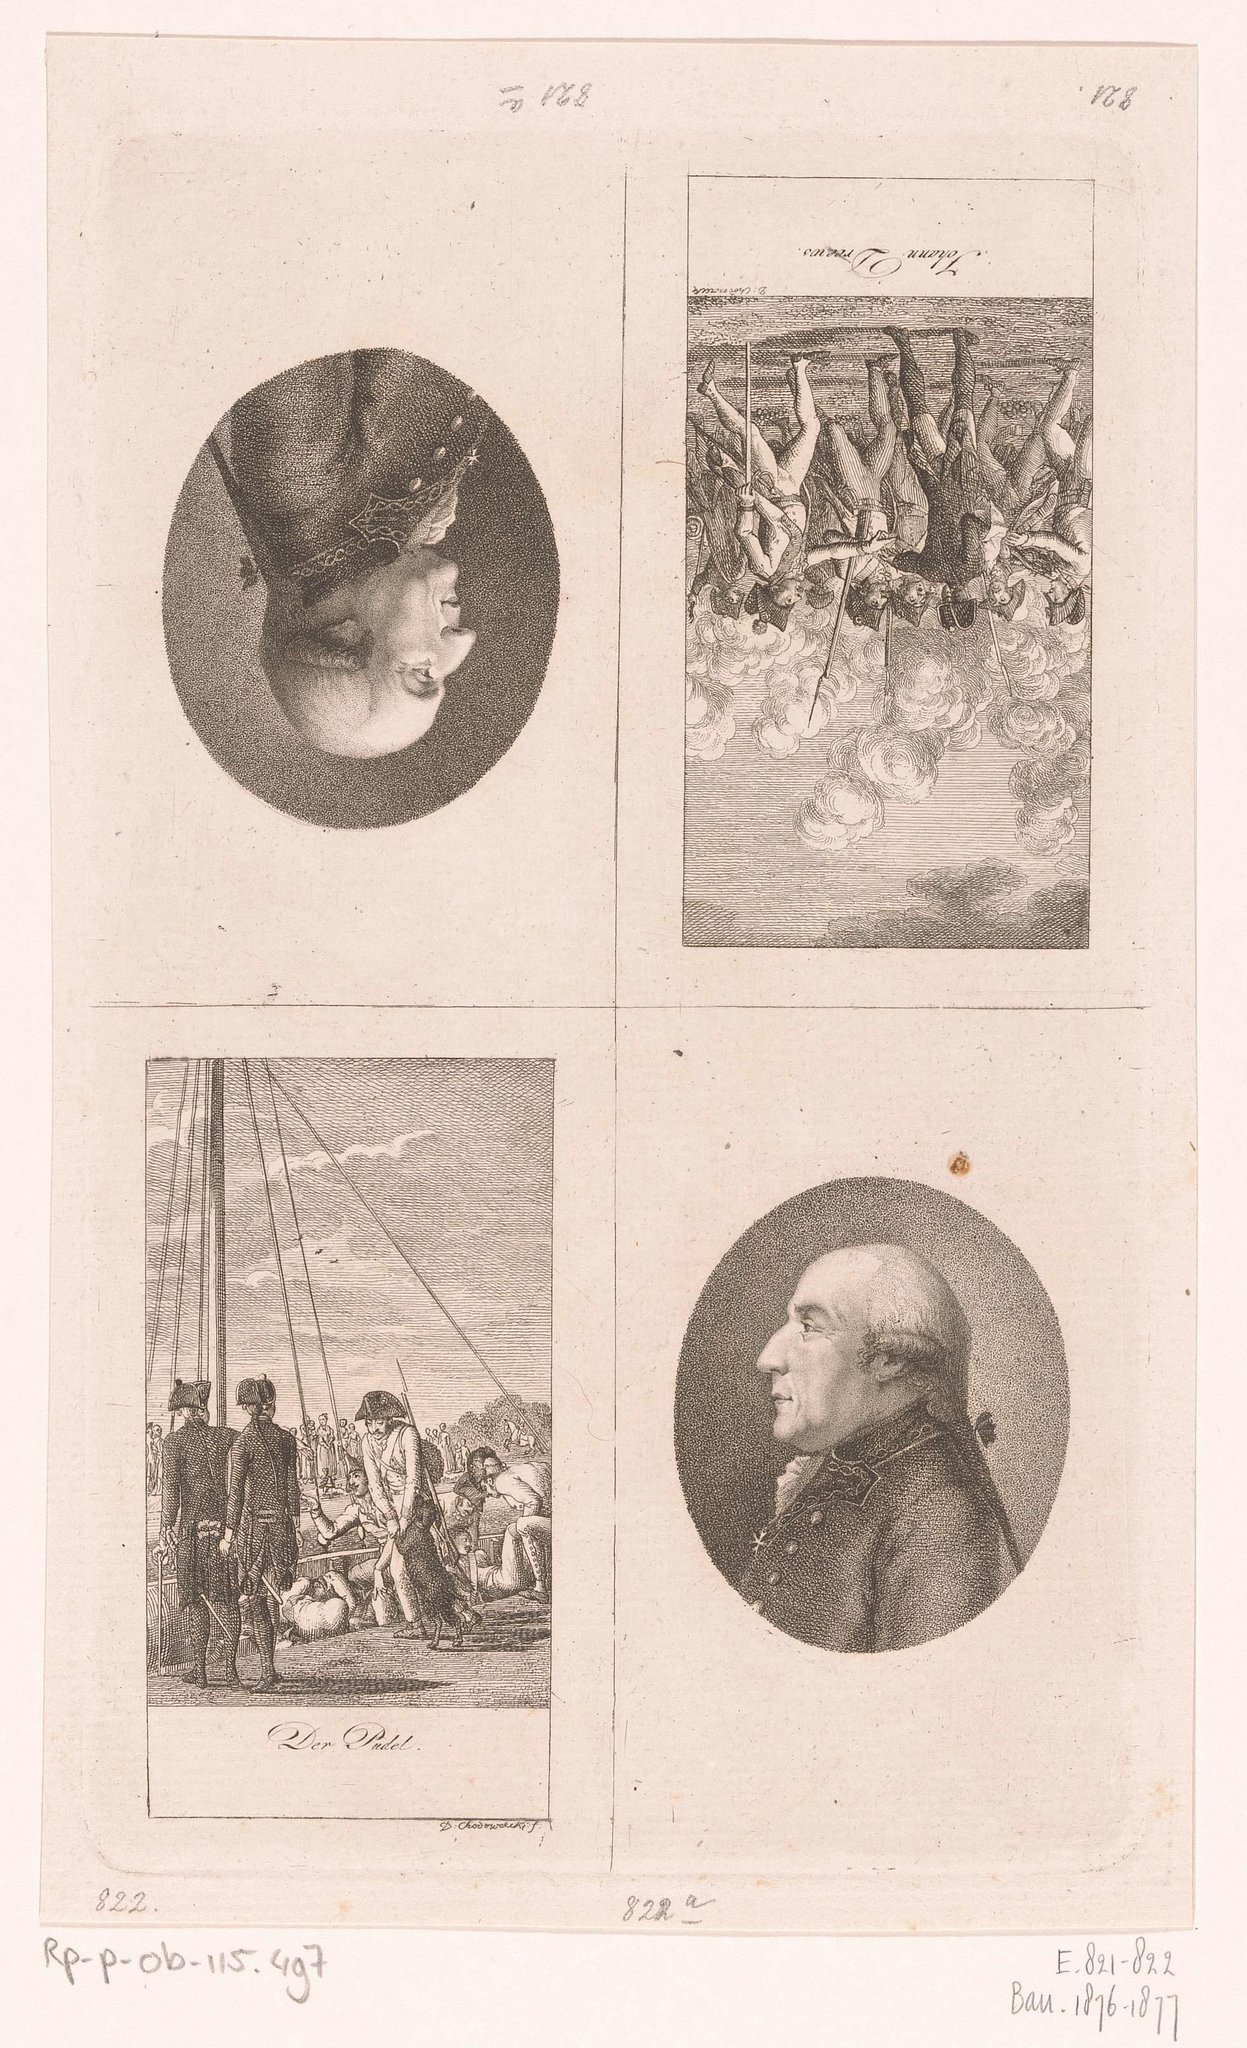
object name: print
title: Twee militaire voorstellingen en tweemaal het portret van Hermann Johann Ernst von Manstein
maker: daniel nikolaus chodowiecki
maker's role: draughtsman, print maker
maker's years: 1726-1801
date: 1796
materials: paper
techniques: etching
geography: berlin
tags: history, the soldier; the soldier's life, quarrel, argument, dog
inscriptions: collector's mark: Lugt 2228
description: Prenten gebruikt voor: Militärischer Kalender auf das Jahr 1797. Berlijn: Johann Friedrich Unger, [1796].